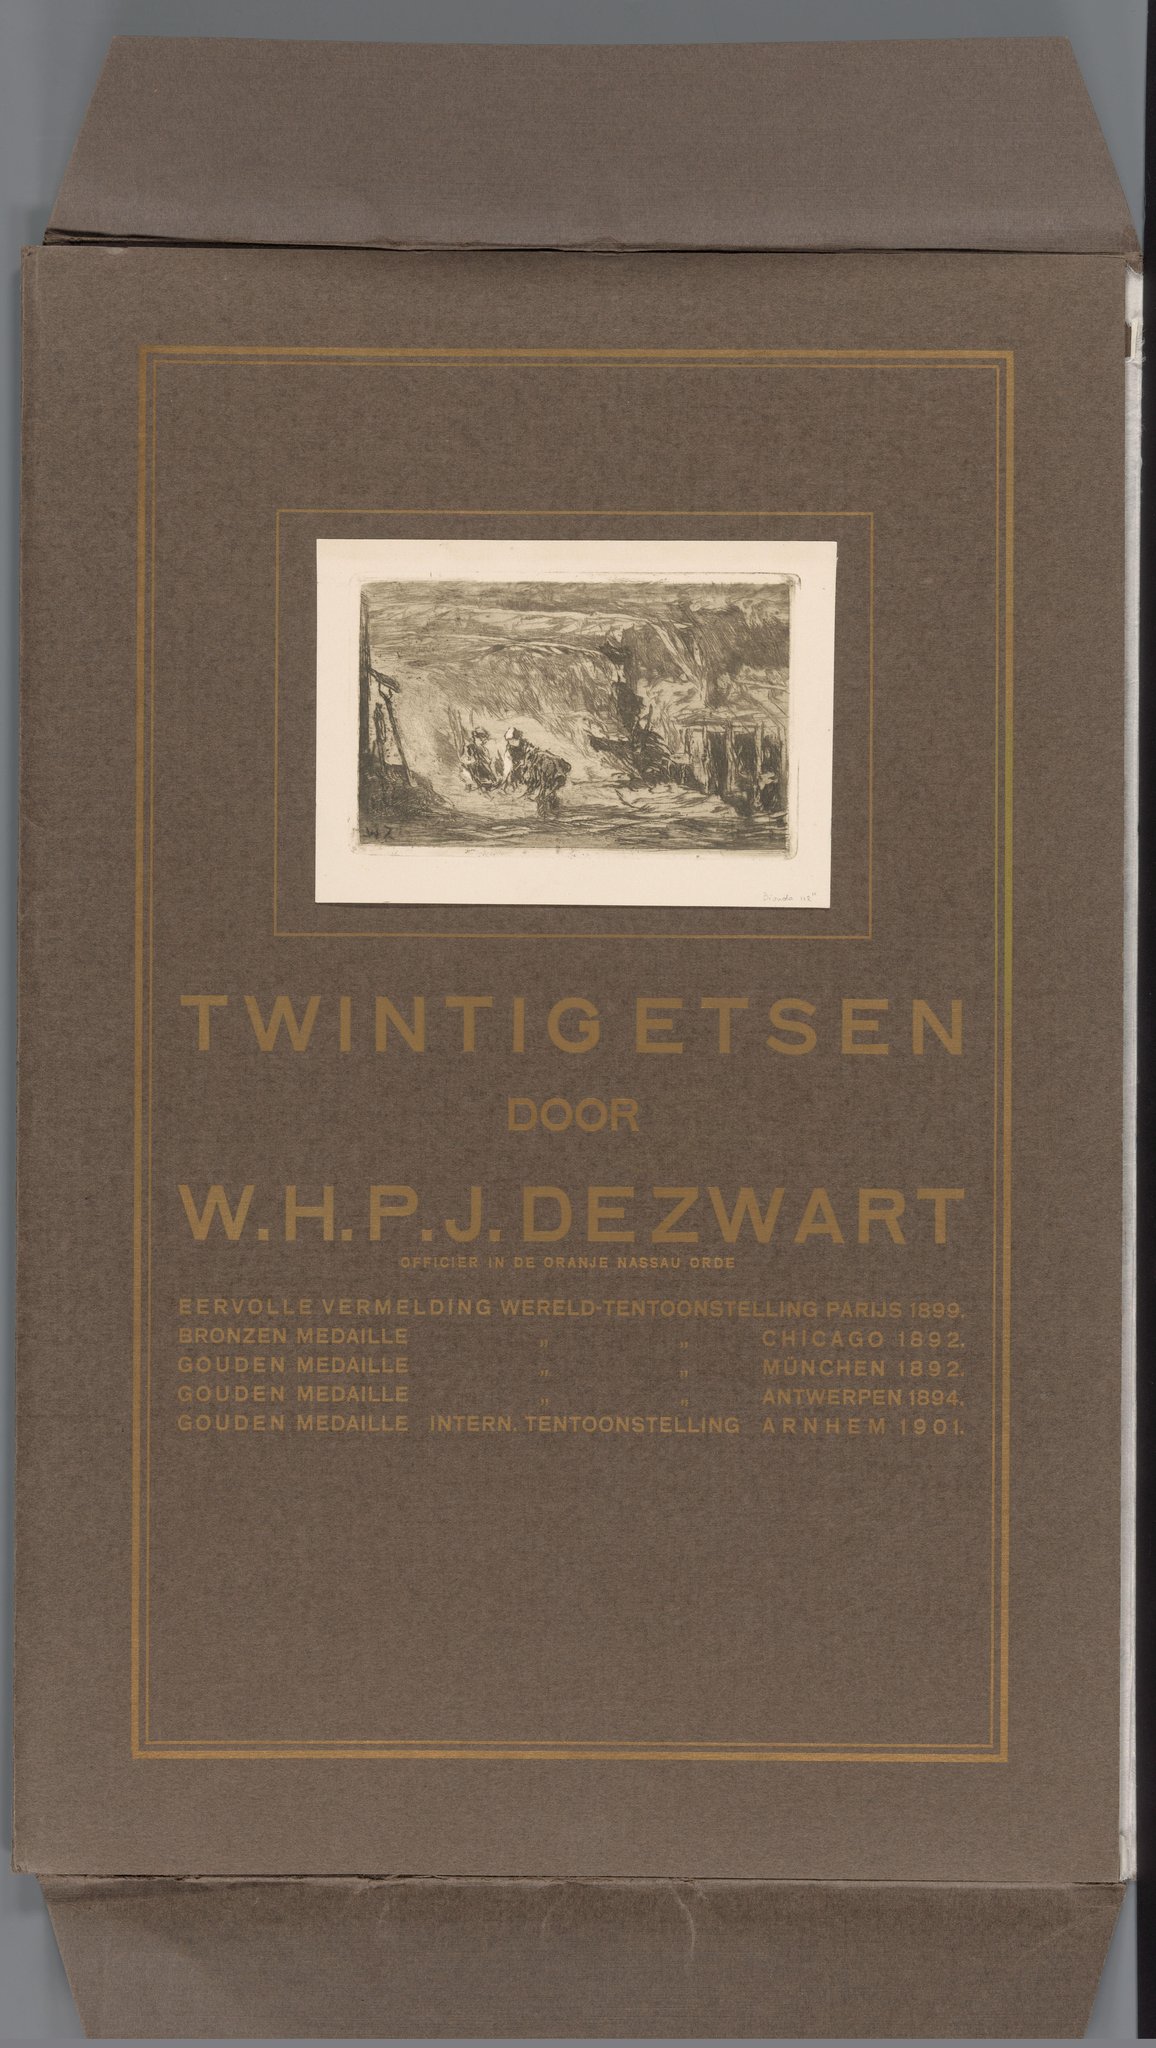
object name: wrapper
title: Twintig etsen door W.H.P.J. de Zwart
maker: willem de zwart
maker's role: draughtsman, painter, print maker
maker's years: 1862-1931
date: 1924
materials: paper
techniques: etching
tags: stall, stable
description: In de literatuur wordt deze omslag de 'Vaartiesuitgave' genoemd.